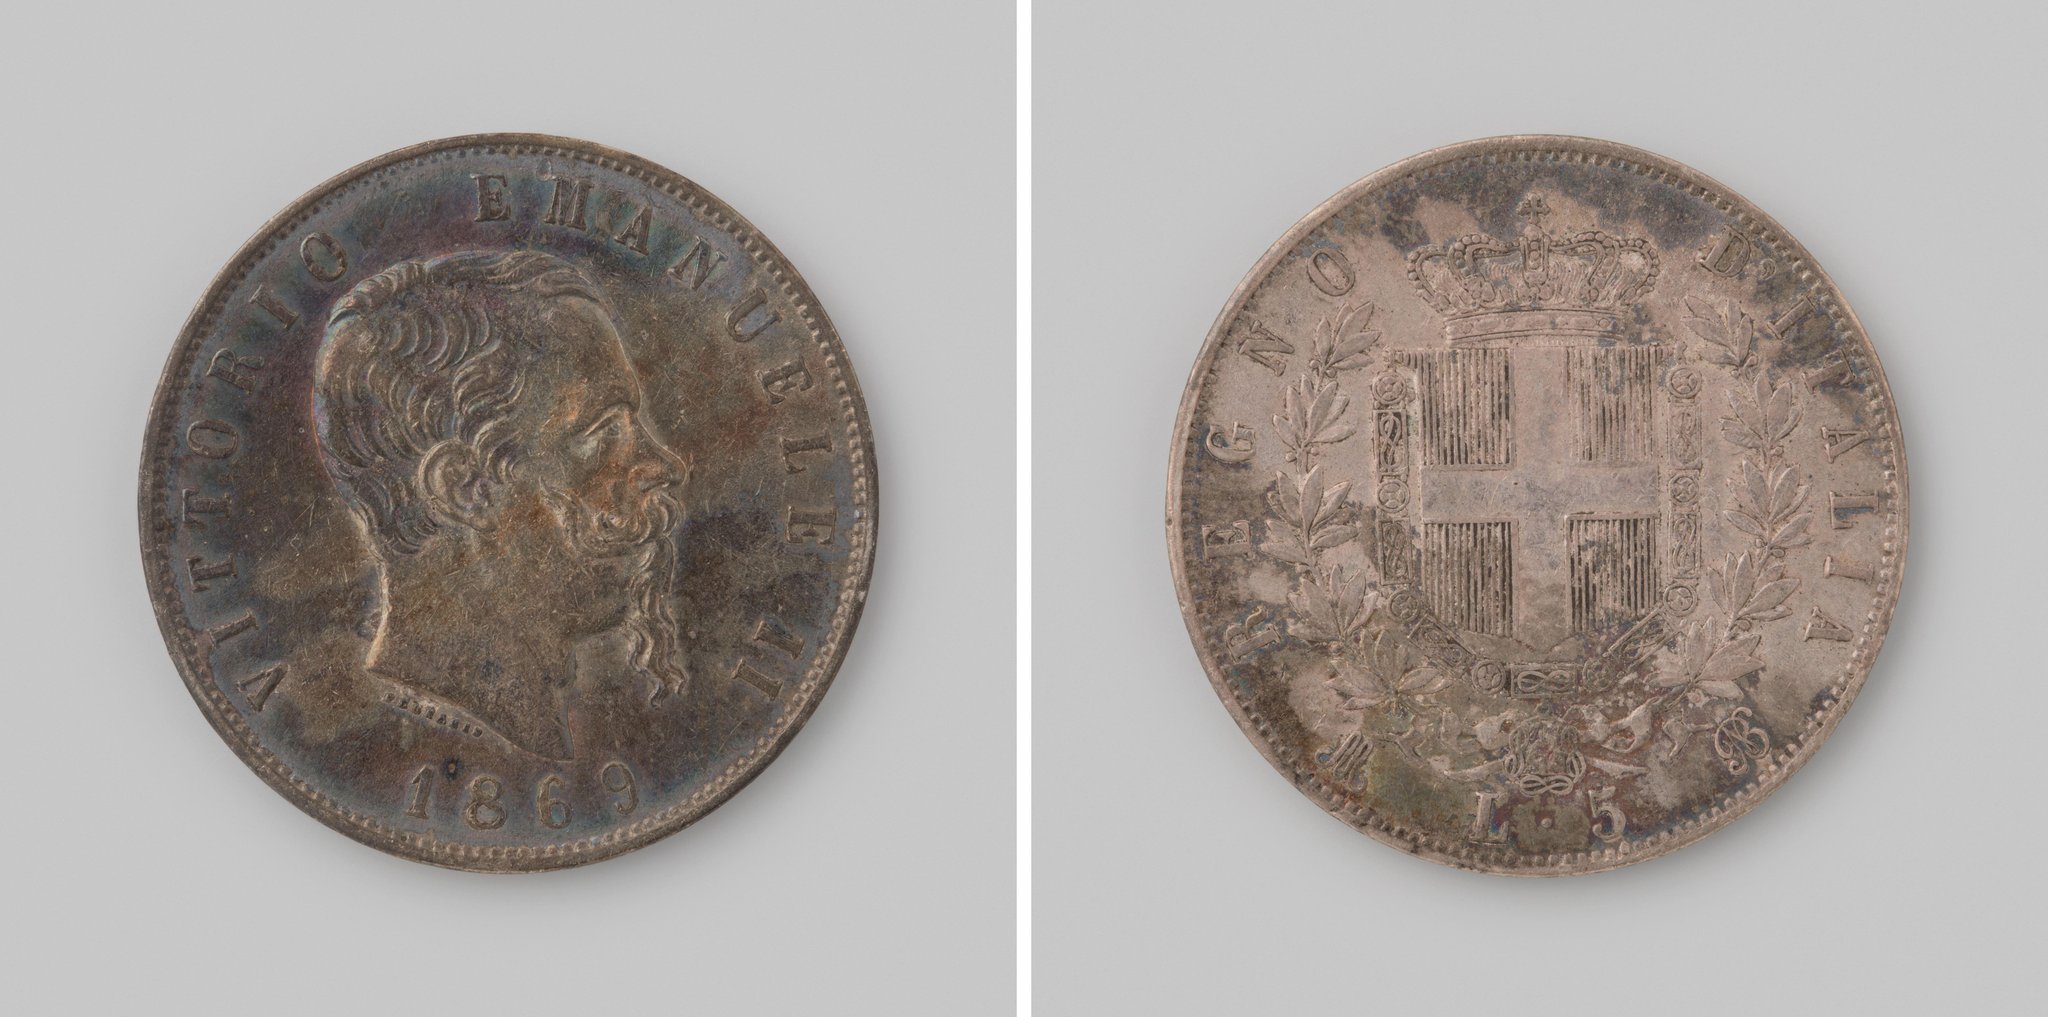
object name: coin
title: 5 lire uit Italië van koning Vittorio Emanuele II, 1869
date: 1869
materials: silver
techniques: striking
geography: milan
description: Zilveren munt. Voorzijde: hoofd van de koning naar rechts. Daaronder jaartal. Keerzijde: binnen twee takken door keten van ridderorde met juweel omhangen gekroond wapenschild. Waarde-aanduiding onderaan in omschrift. Links daarvan muntteken: letter M [=Milaan]. Randschrift.